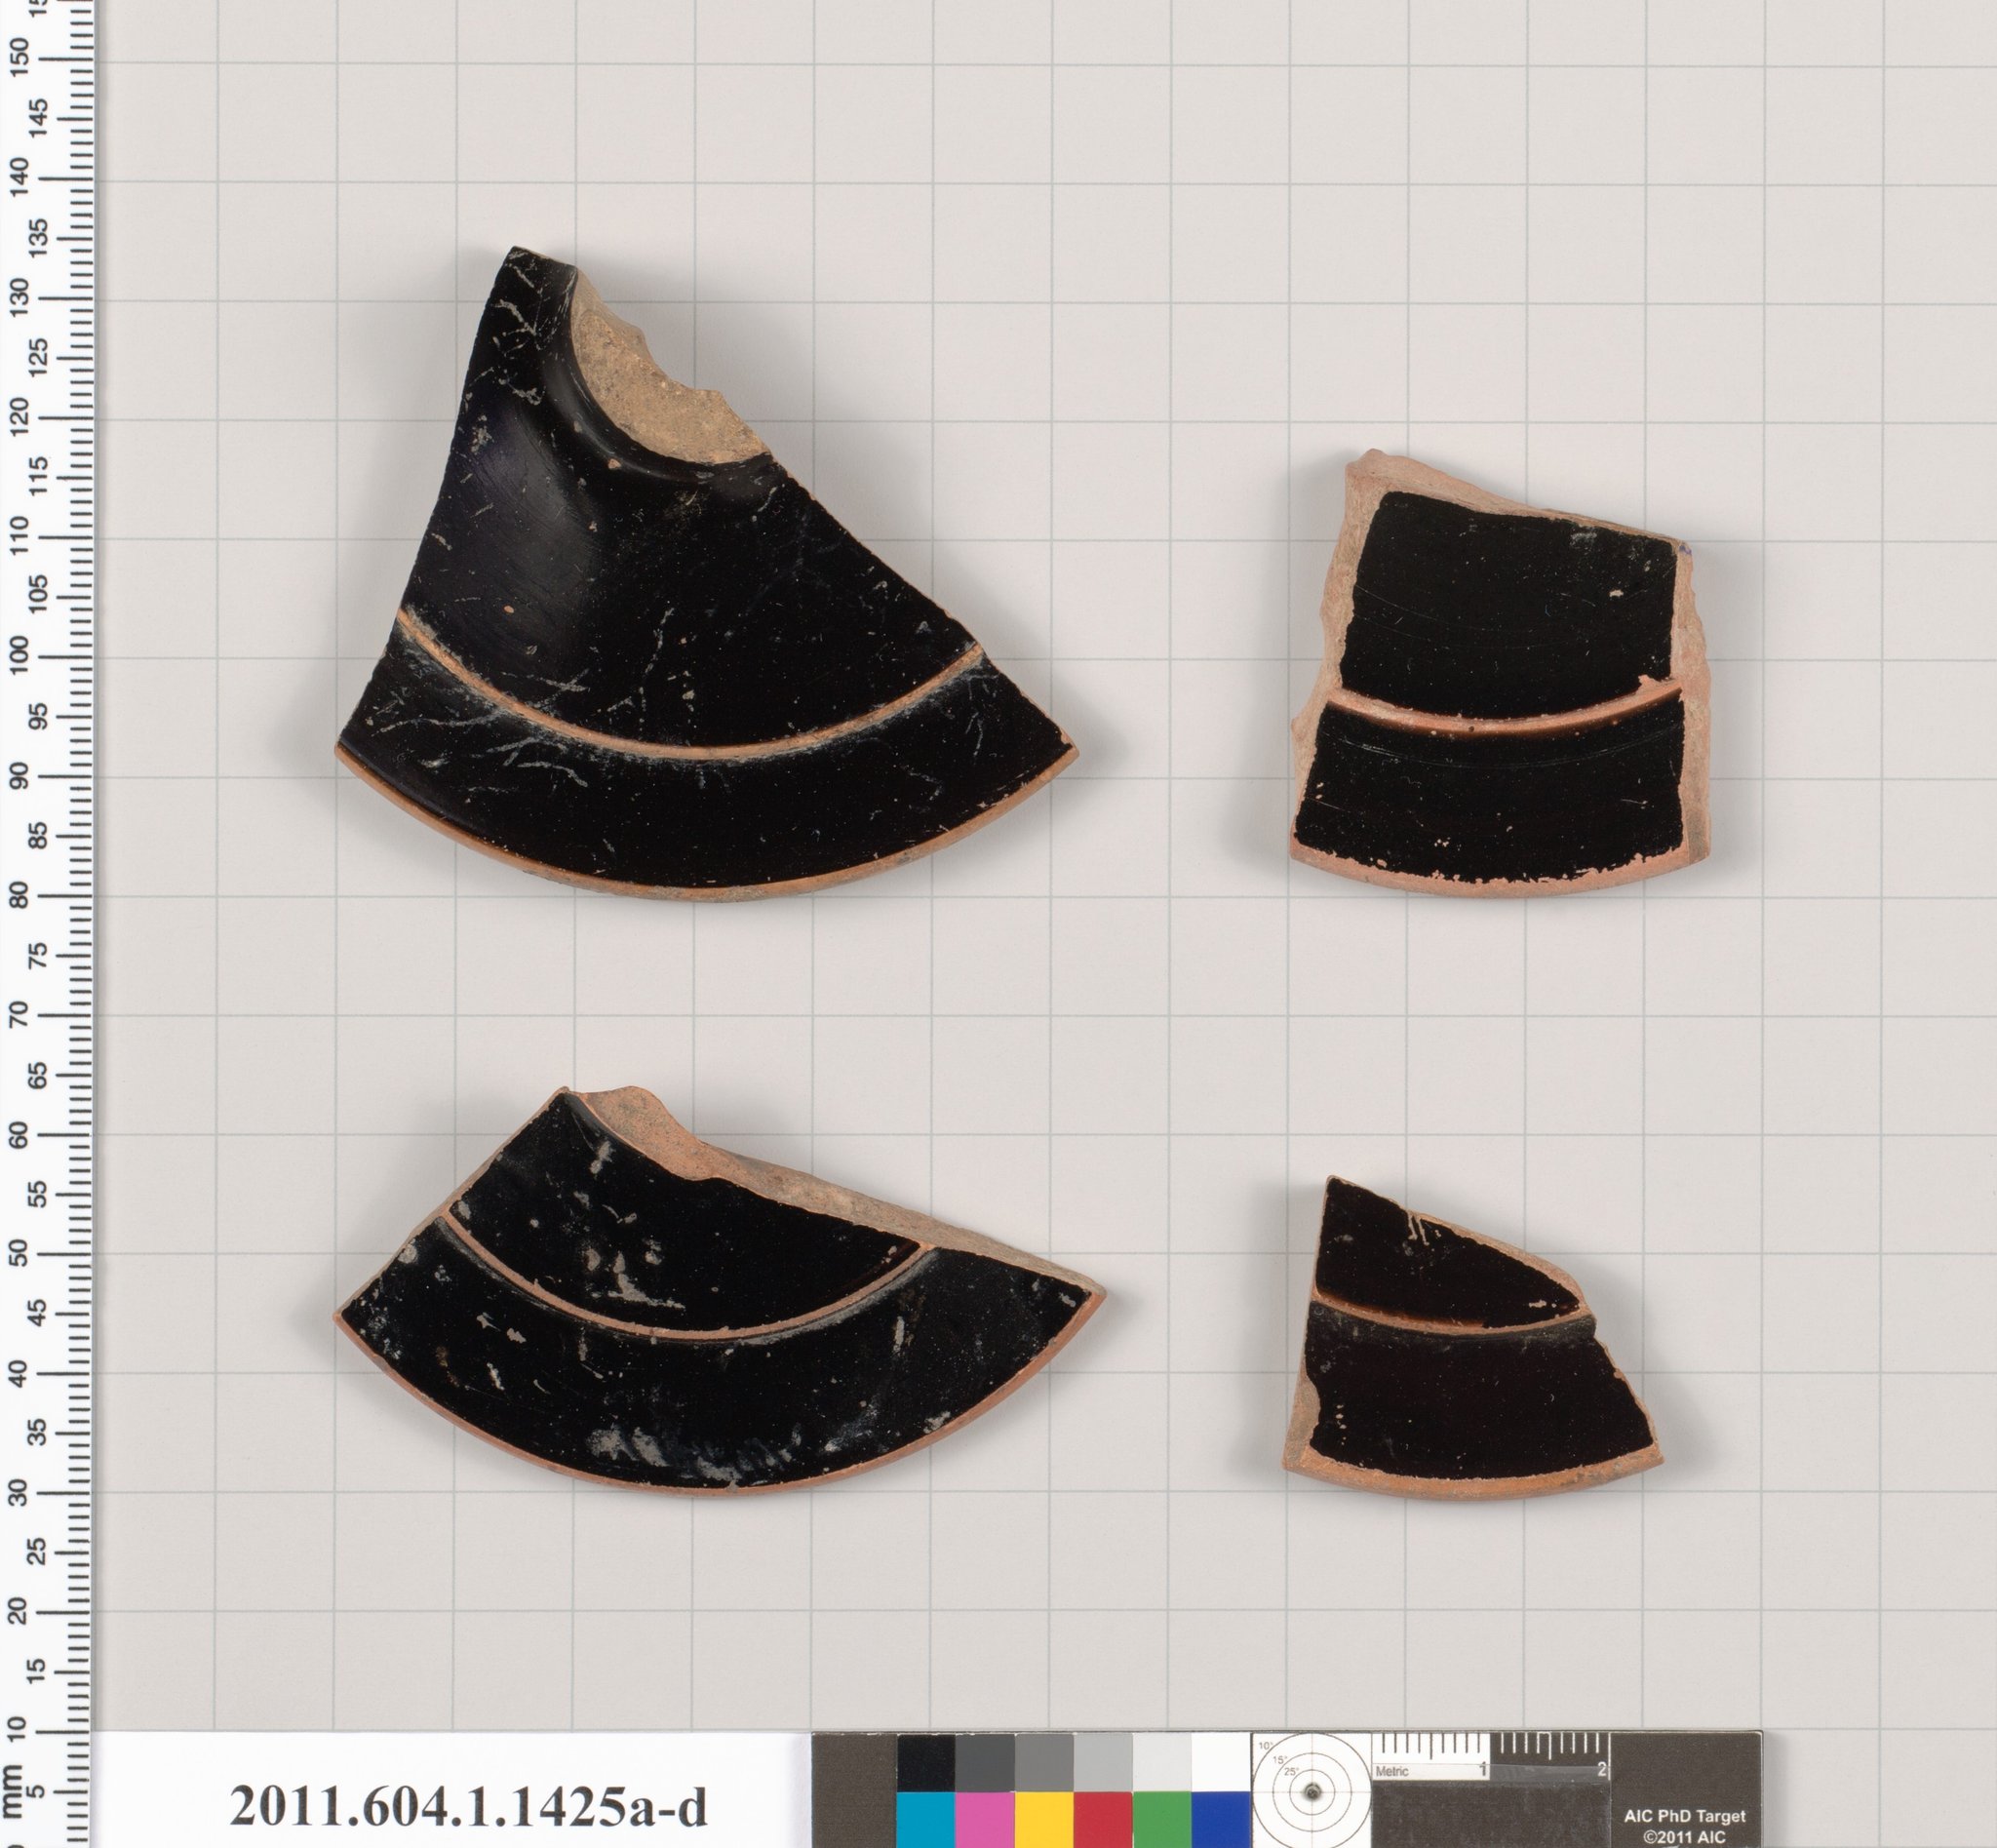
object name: kylix fragment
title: Terracotta fragments of kylikes (drinking cups)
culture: greek, attic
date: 500-401 BCE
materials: terracotta